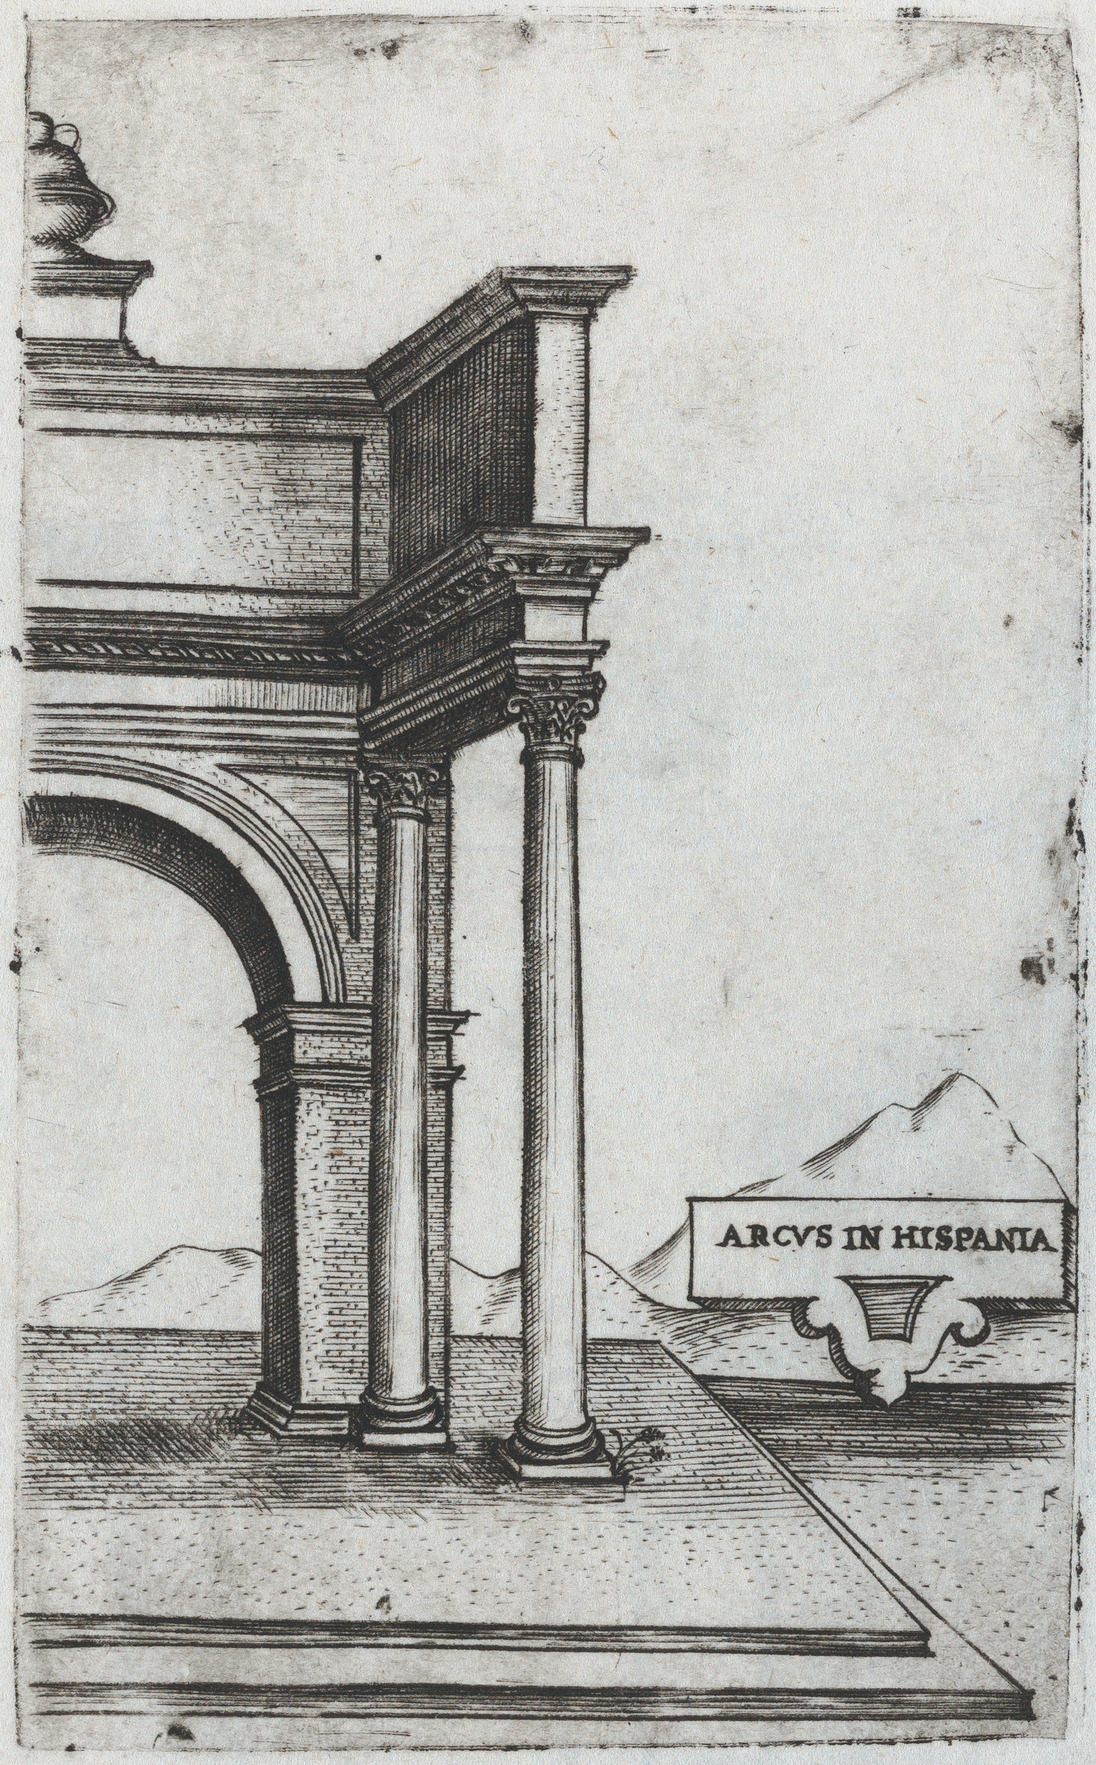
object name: album print ornament architecture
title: Pantheon Rome, from a Series of Prints depicting (reconstructed) Buildings from Roman Antiquity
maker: monogrammist g.a. with the caltrop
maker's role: artist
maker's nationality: italian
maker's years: 1535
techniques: engraving, printing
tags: architecture,arches